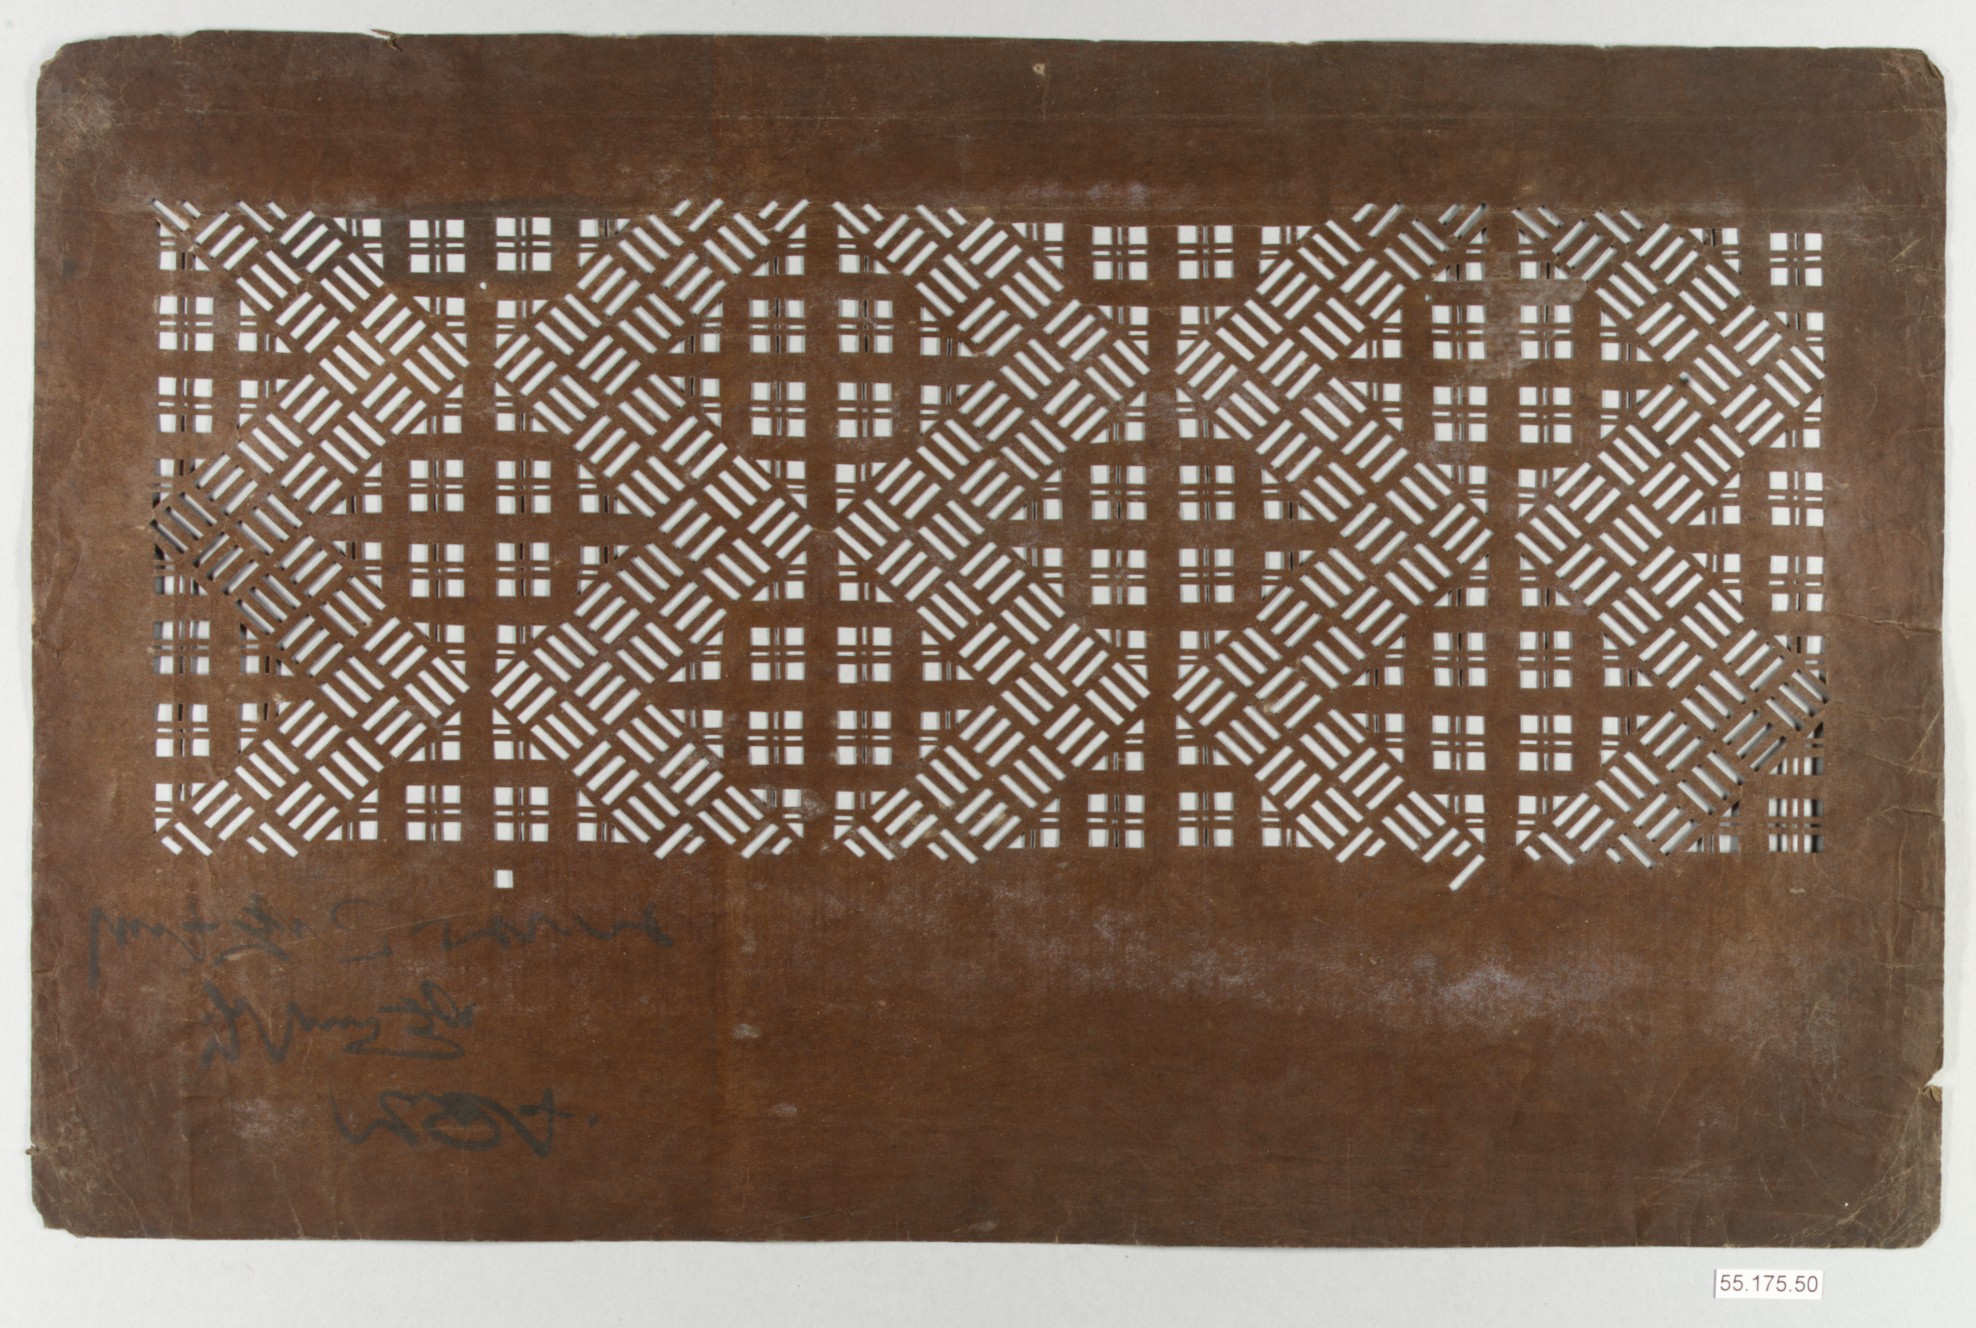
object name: stencil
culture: japanese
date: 1801-1900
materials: paper